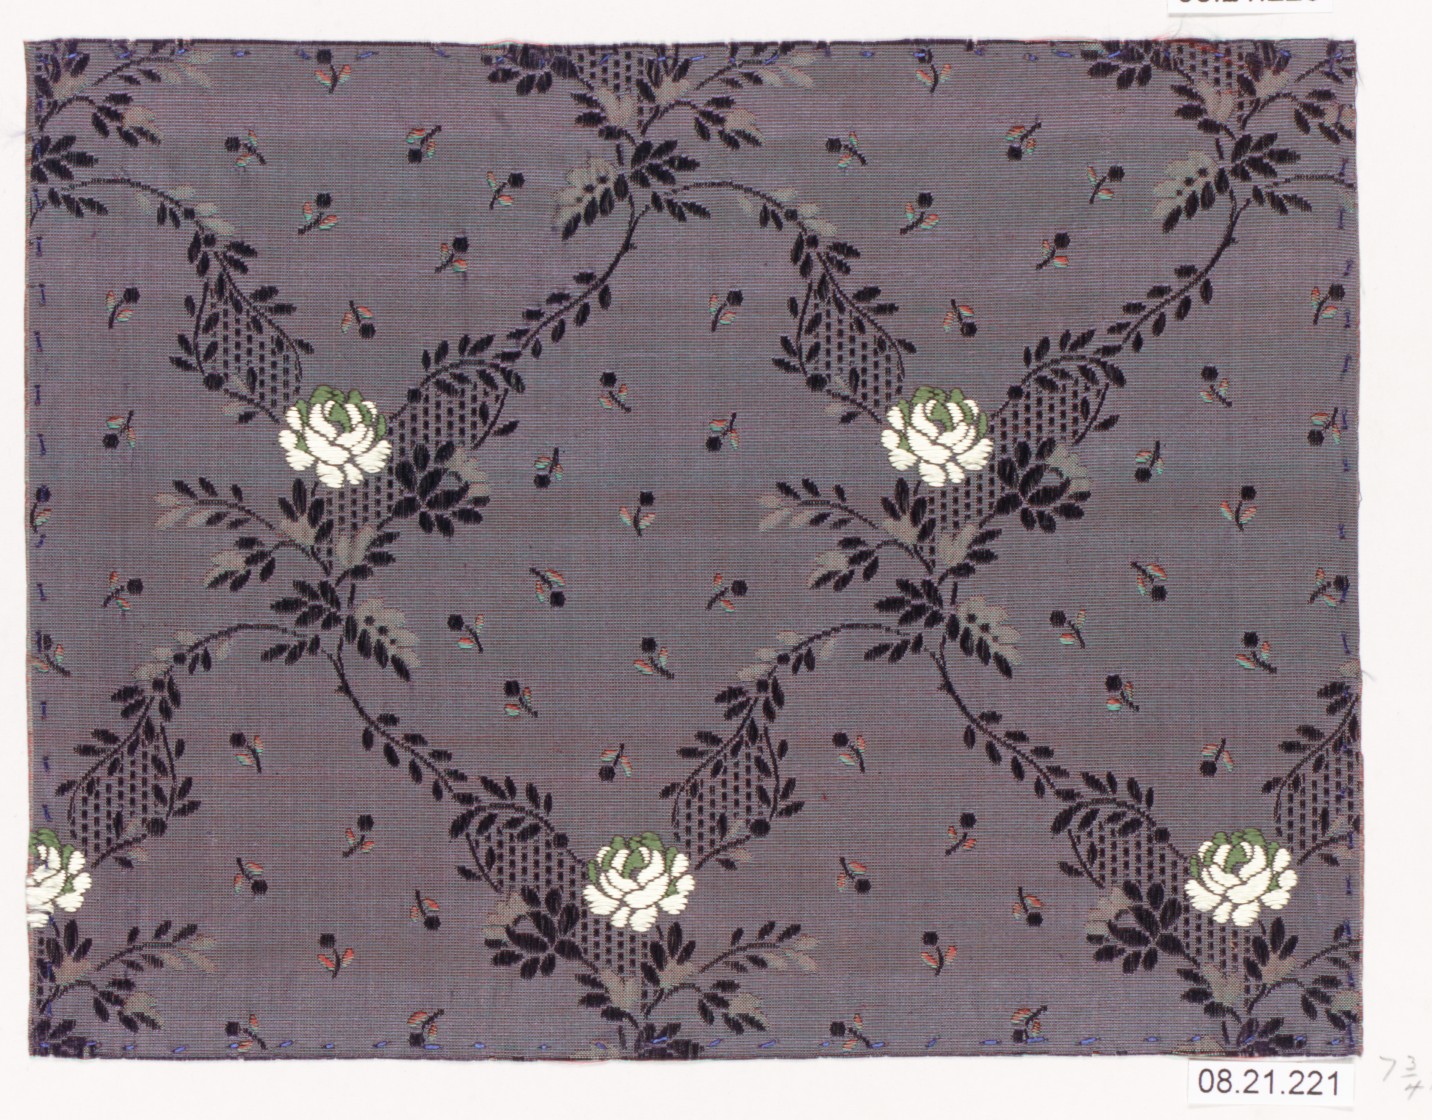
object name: textile sample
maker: Anonymous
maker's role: designer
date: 1900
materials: silk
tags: flowers